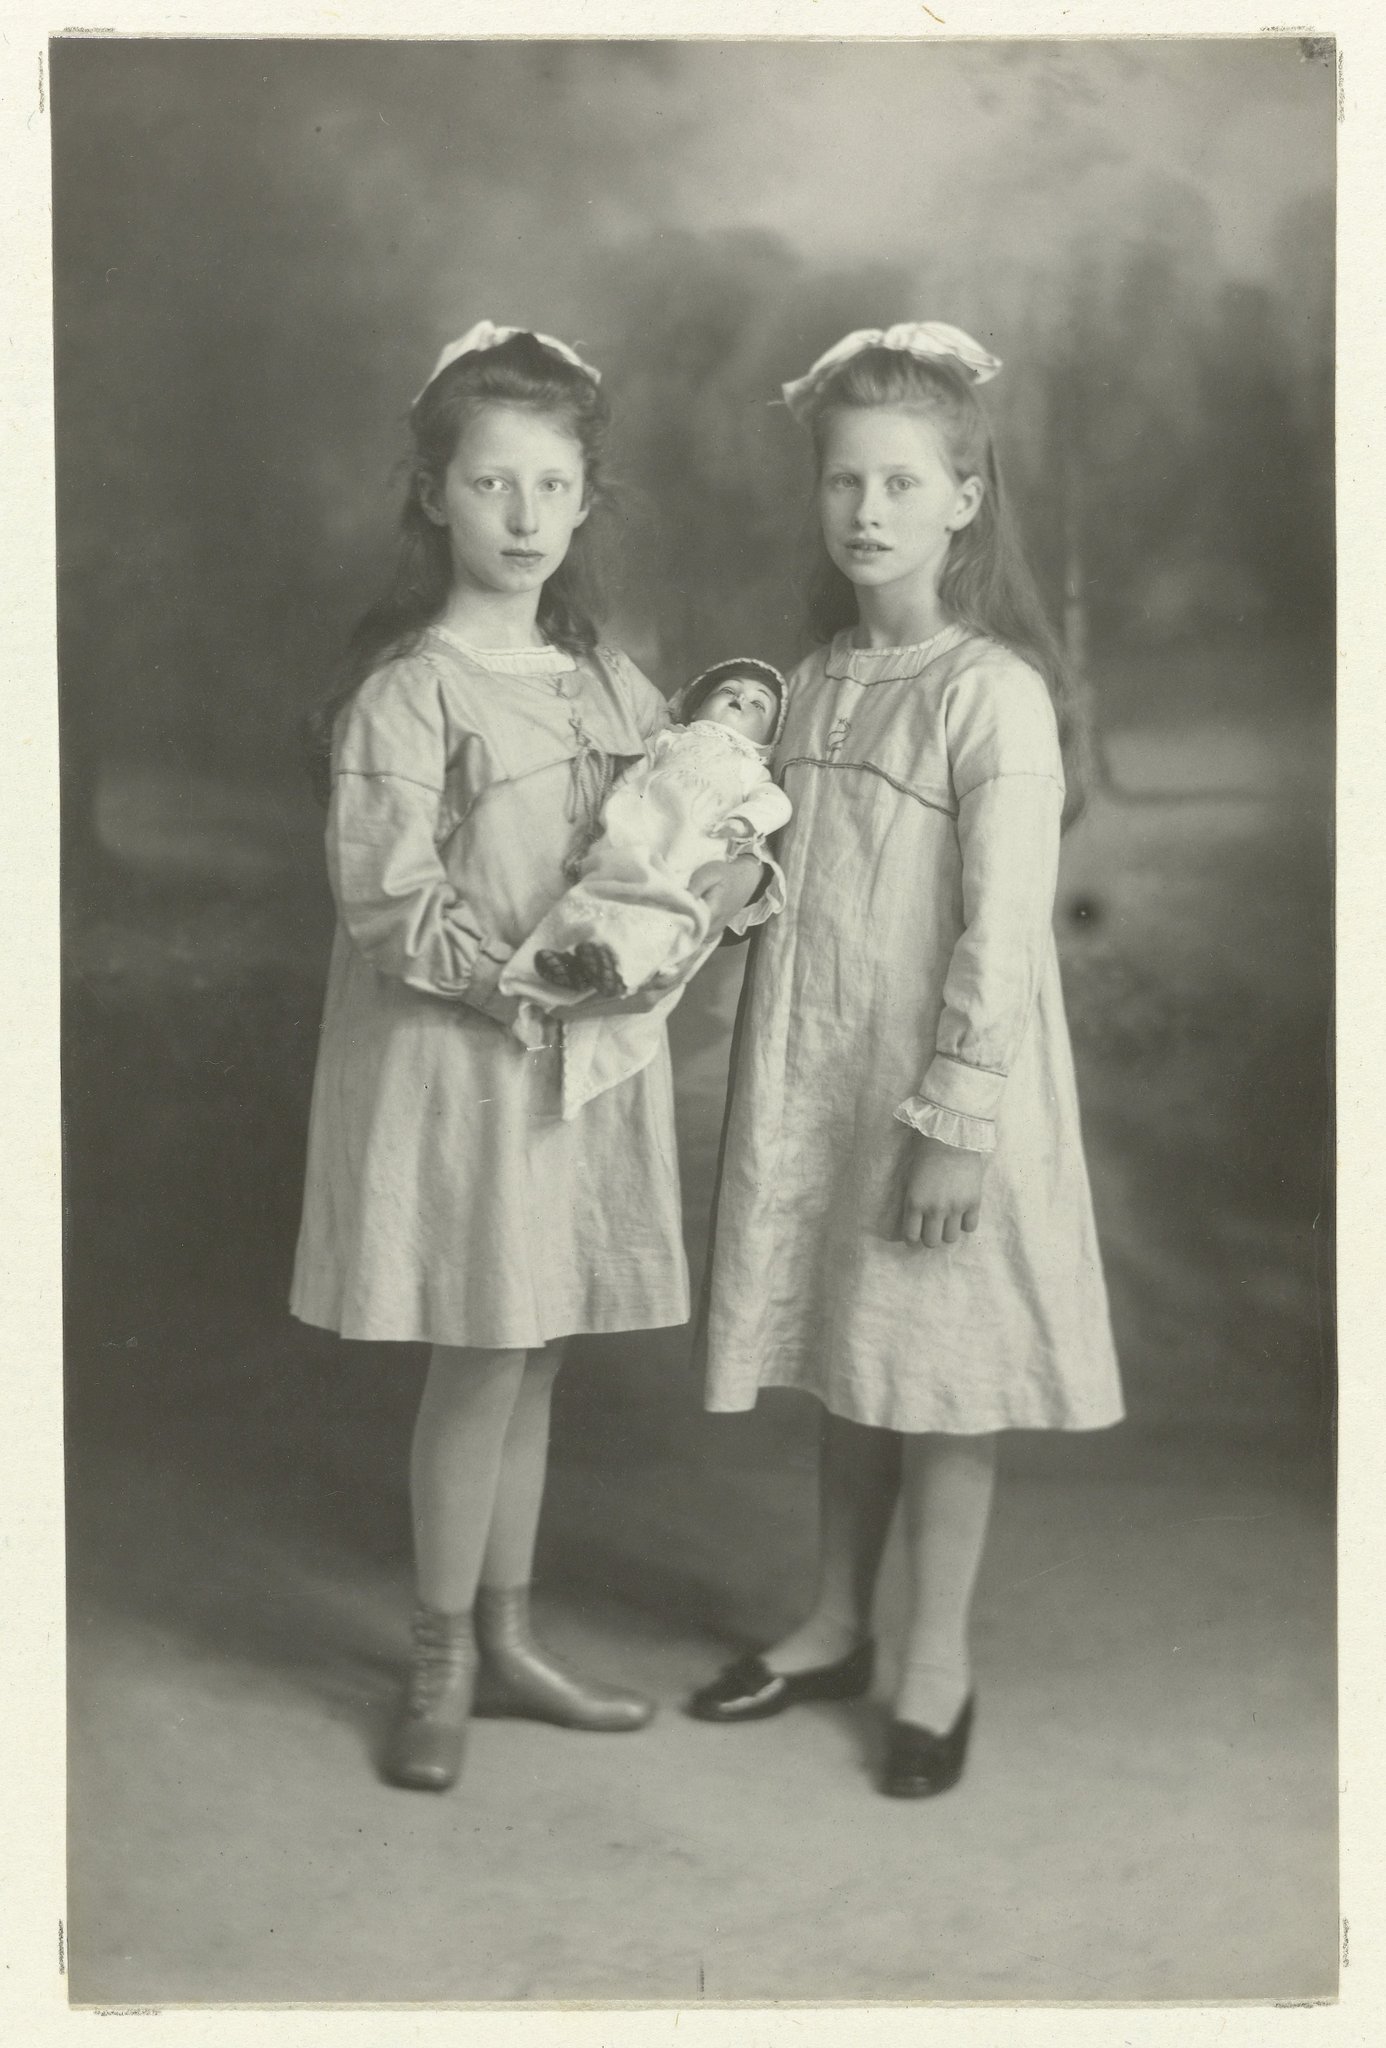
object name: photograph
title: Susanna Frida en Anna Clara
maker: Anonymous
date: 1919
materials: paper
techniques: gelatin silver print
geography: netherlands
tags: girl (child between toddler and youth)